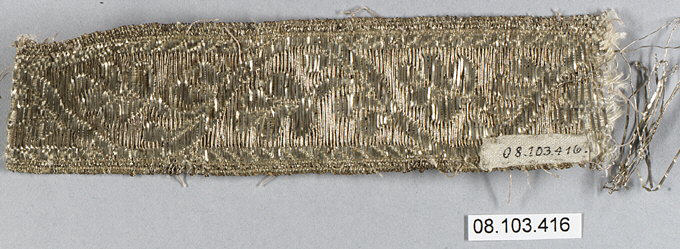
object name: galloon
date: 1701-1800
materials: metal thread